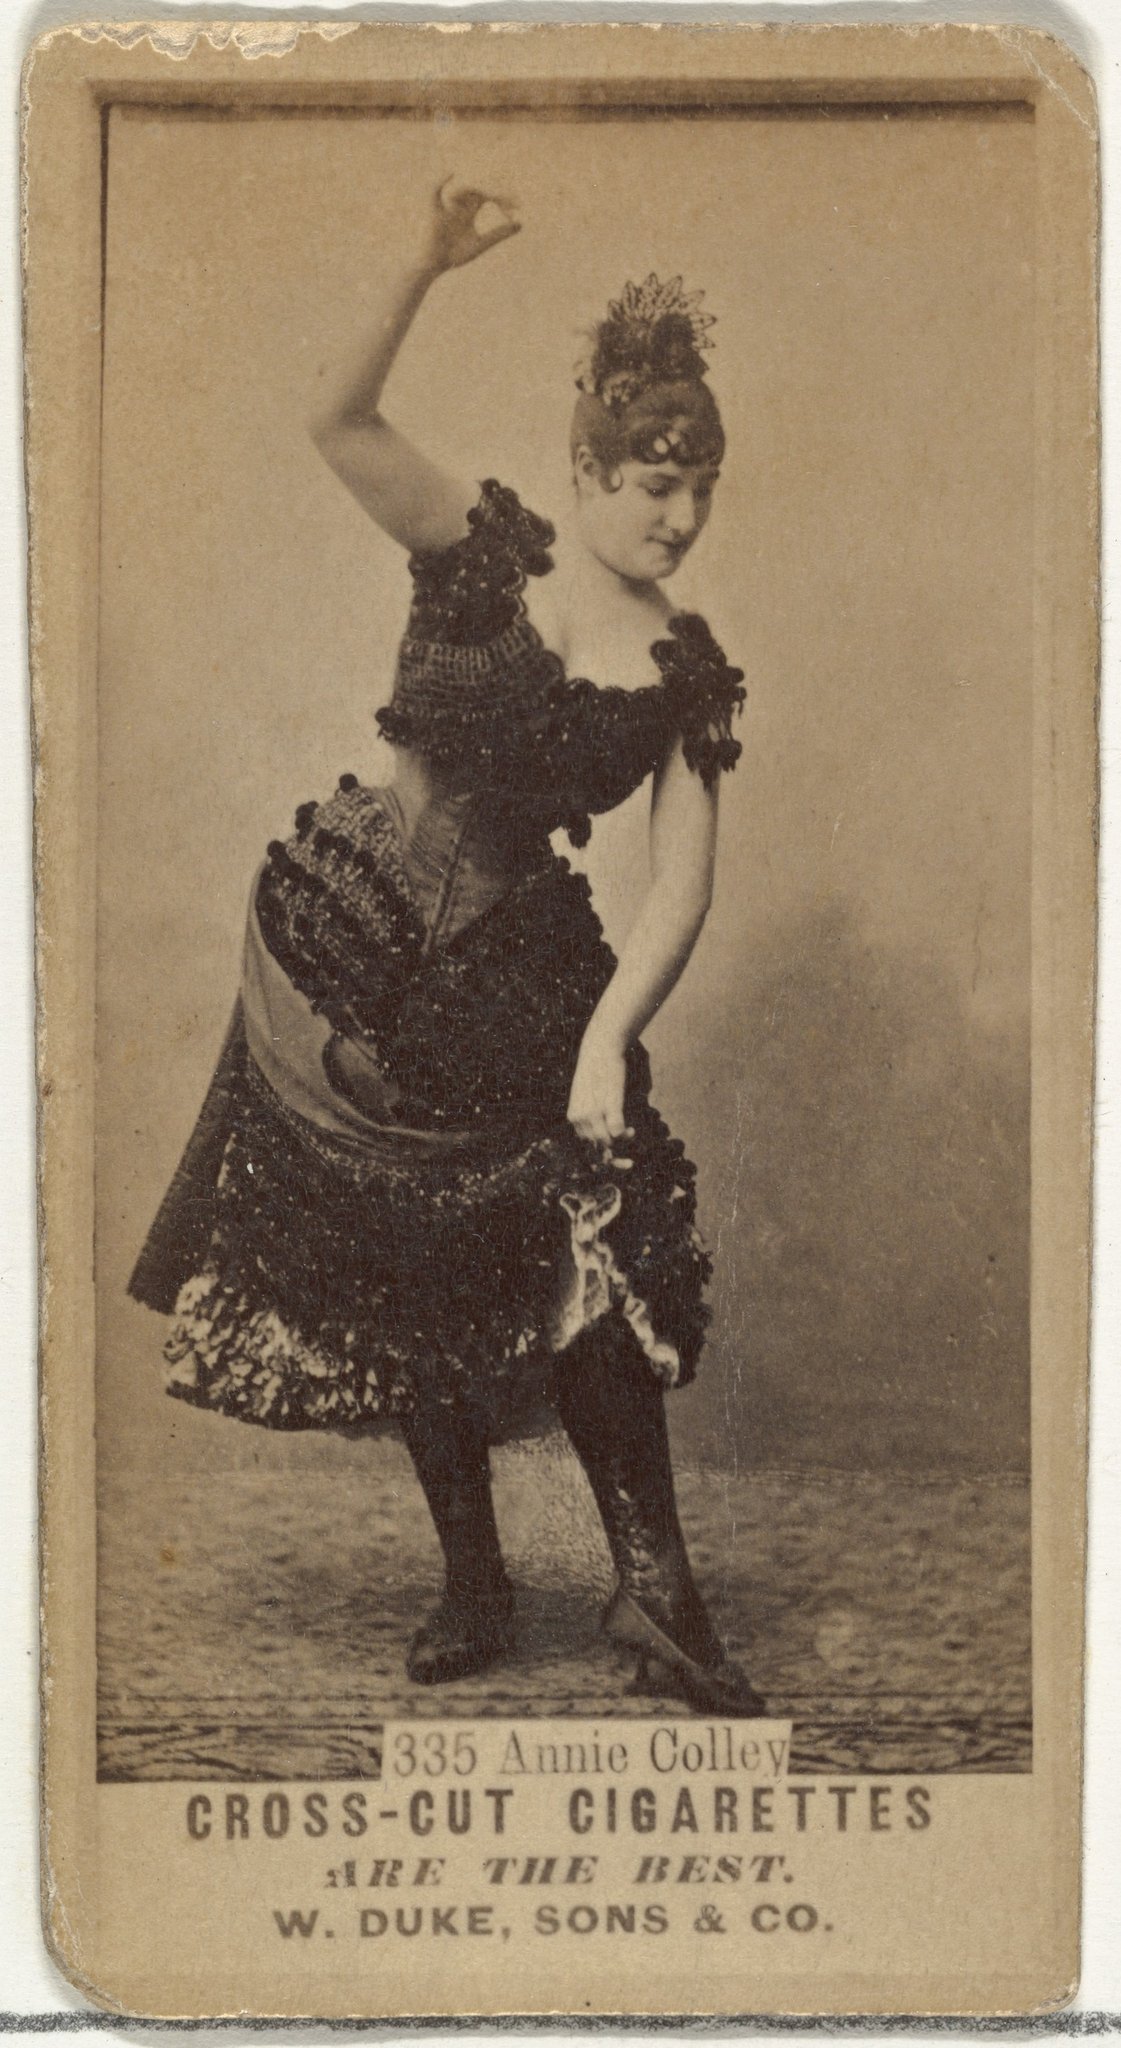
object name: photograph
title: Card Number 335, Annie Colley, from the Actors and Actresses series (N145-3) issued by Duke Sons & Co. to promote Cross Cut Cigarettes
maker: w. duke, sons & co.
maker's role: publisher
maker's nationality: american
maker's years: 1870-1920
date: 1880-1889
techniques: albumen silver print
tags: portraits,women,dancing,actresses